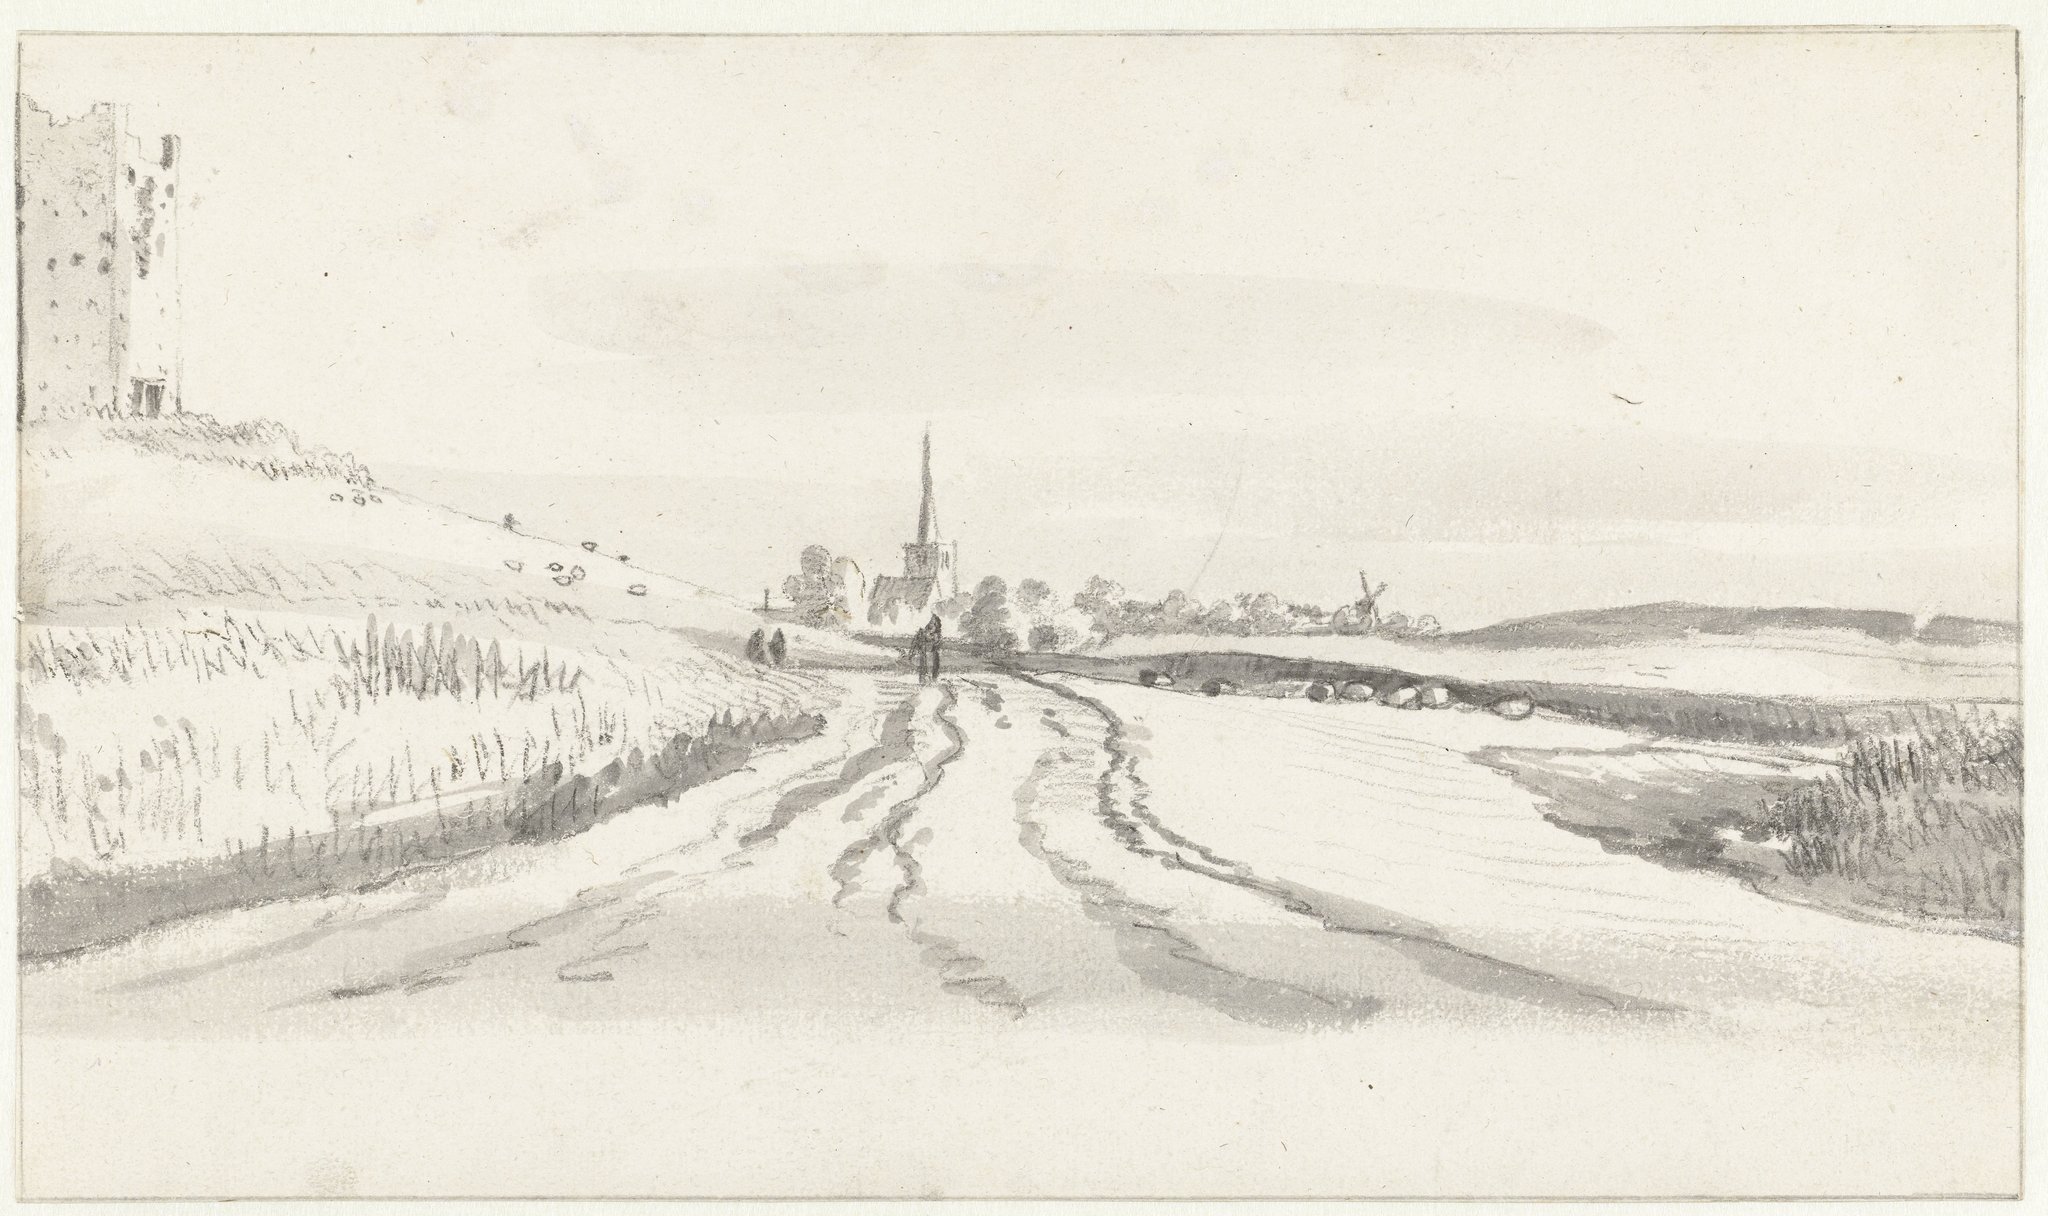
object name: drawing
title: View of the Village of Almkerk, with Huis Altena on the Left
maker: roelant roghman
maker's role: draughtsman, painter, print maker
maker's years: 1627-1692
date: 1646-1647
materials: chalk, ink, paper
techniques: brush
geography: altena castle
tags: city-view, and landscape with man-made constructions, castle, ruin of a building ~ architecture, kasteel altena